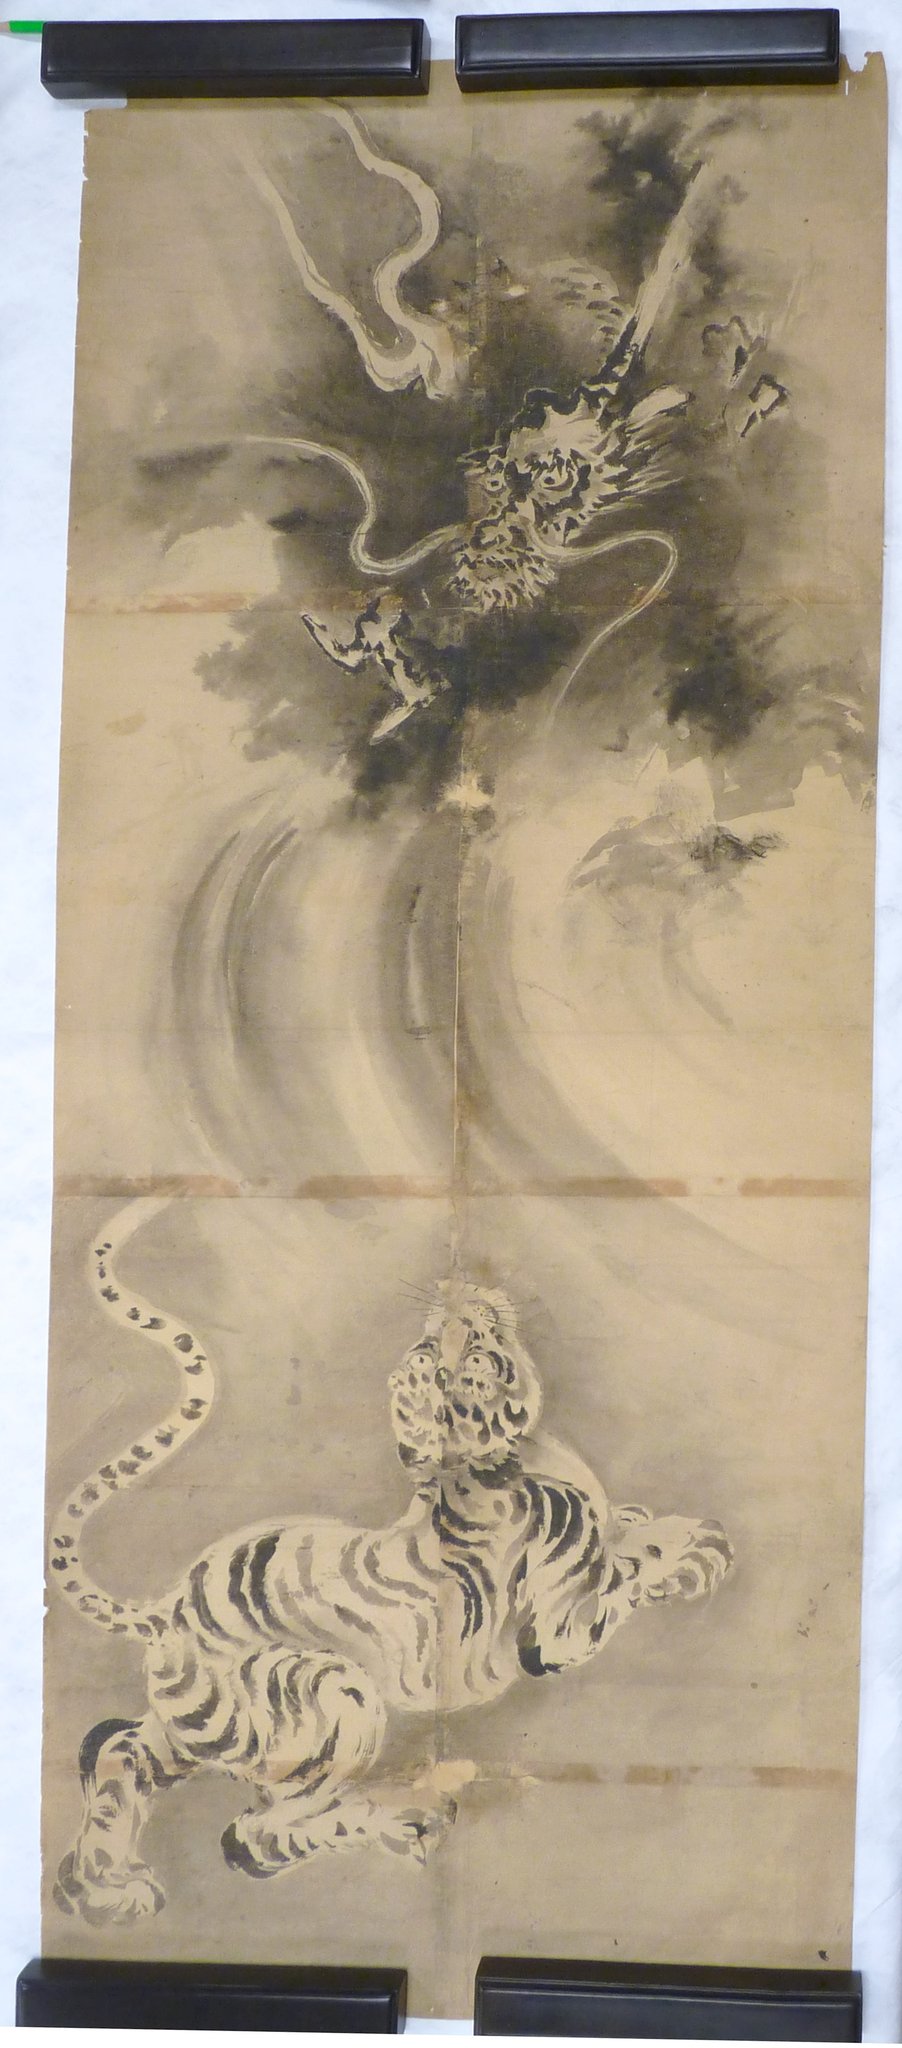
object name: drawing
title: Japanese Drawing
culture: japanese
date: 1801-1833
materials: paper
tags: animals